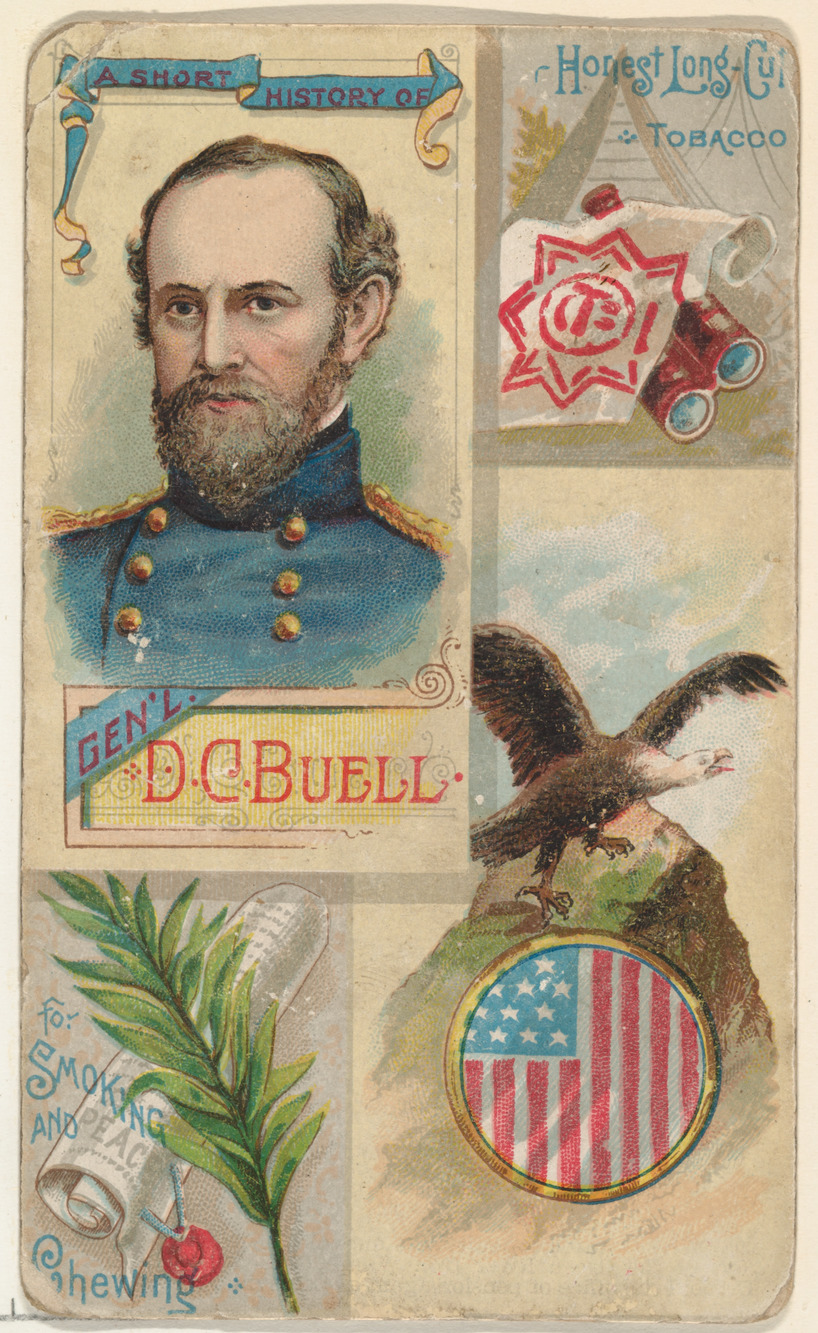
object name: print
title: A Short History of General Don Carlos Buell, from the Histories of Generals series (N114) issued by W. Duke, Sons & Co. to promote Honest Long Cut Smoking and Chewing Tobacco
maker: w. duke, sons & co.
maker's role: publisher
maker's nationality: american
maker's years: 1870-1920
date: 1888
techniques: color lithograph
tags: men,portraits,generals